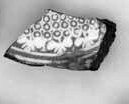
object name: shard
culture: korean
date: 1401-1500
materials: pottery